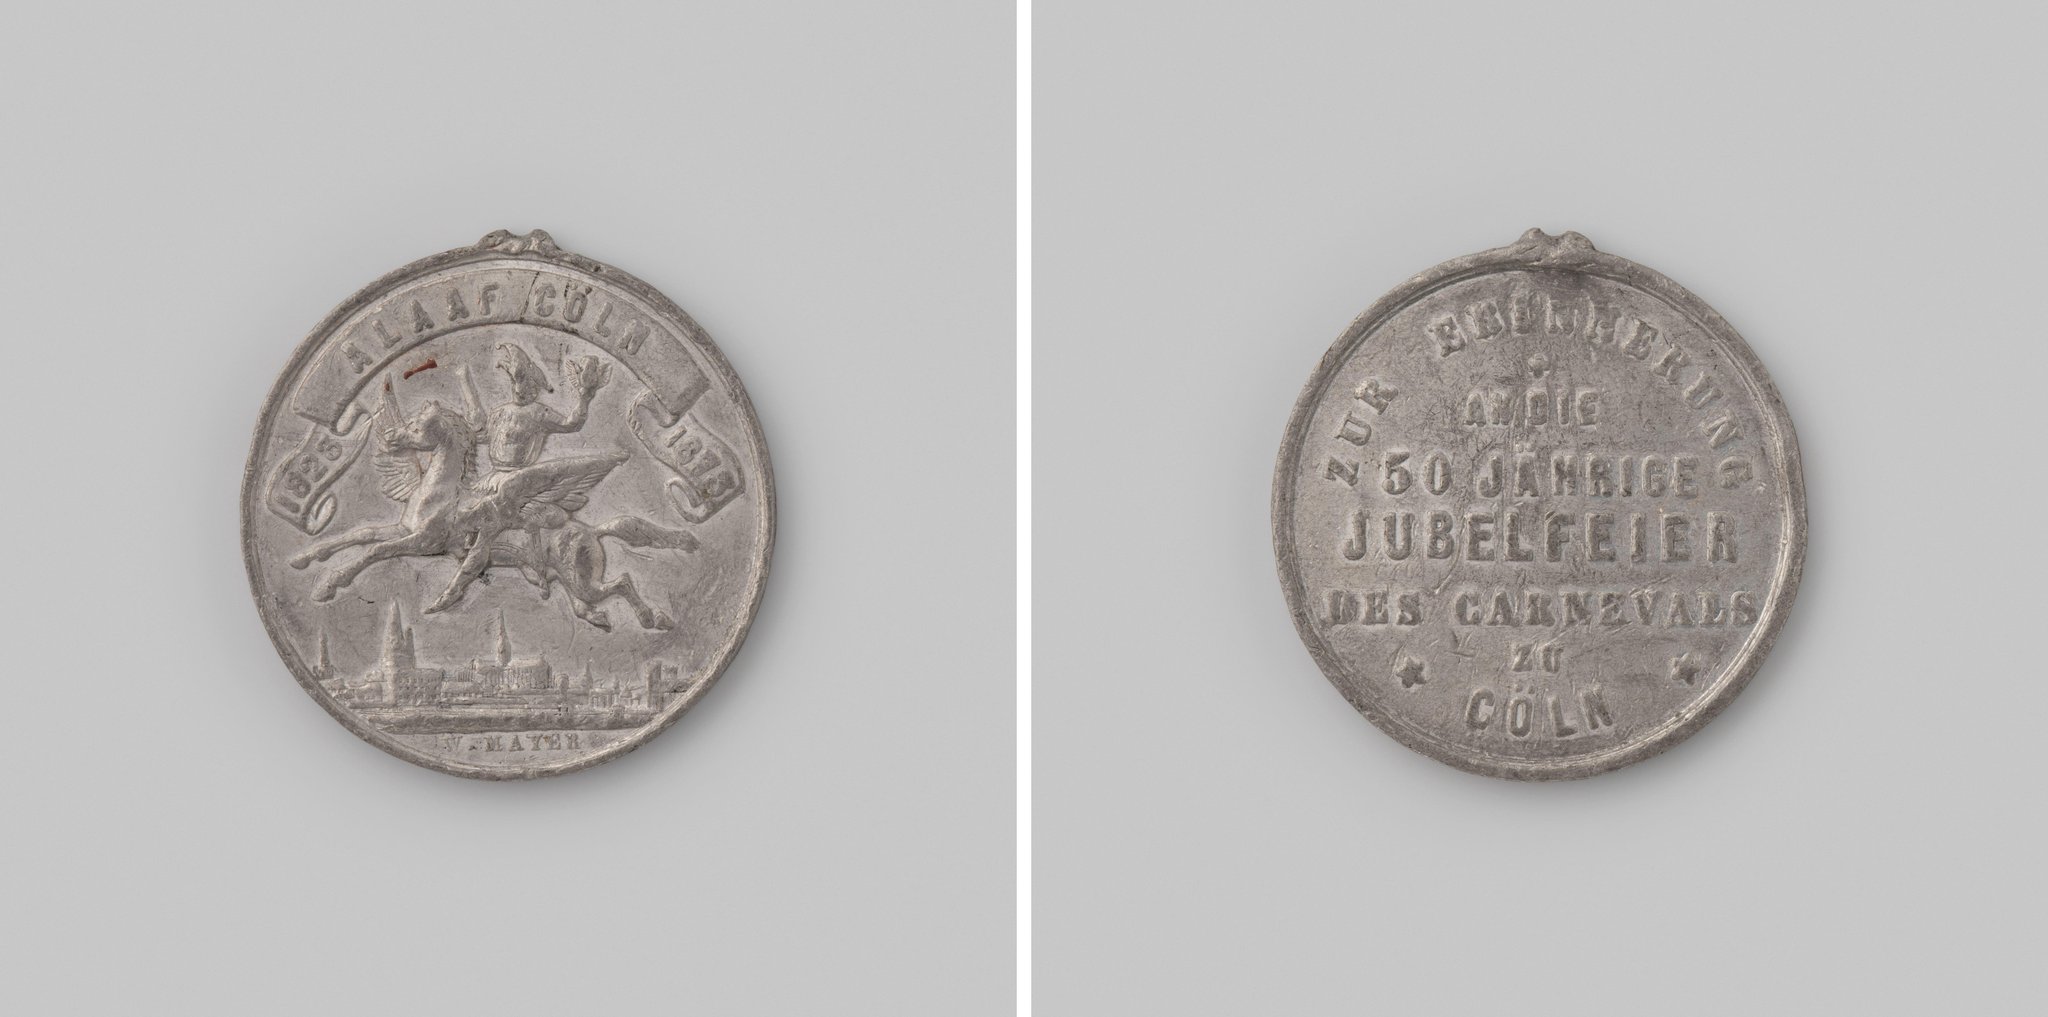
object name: history medal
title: Vijftigjarig Jubelfeest van het Carnaval te Keulen 1873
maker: w. mayer (i)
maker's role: fotograaf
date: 1873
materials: tin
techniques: striking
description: Tinnen penning met verwijderd draagoog, op de voorzijde Prins Carnaval op een gevleugeld paard boven Keulen met bovenaan een banderol, op de keerzijde zeven regels tekst.